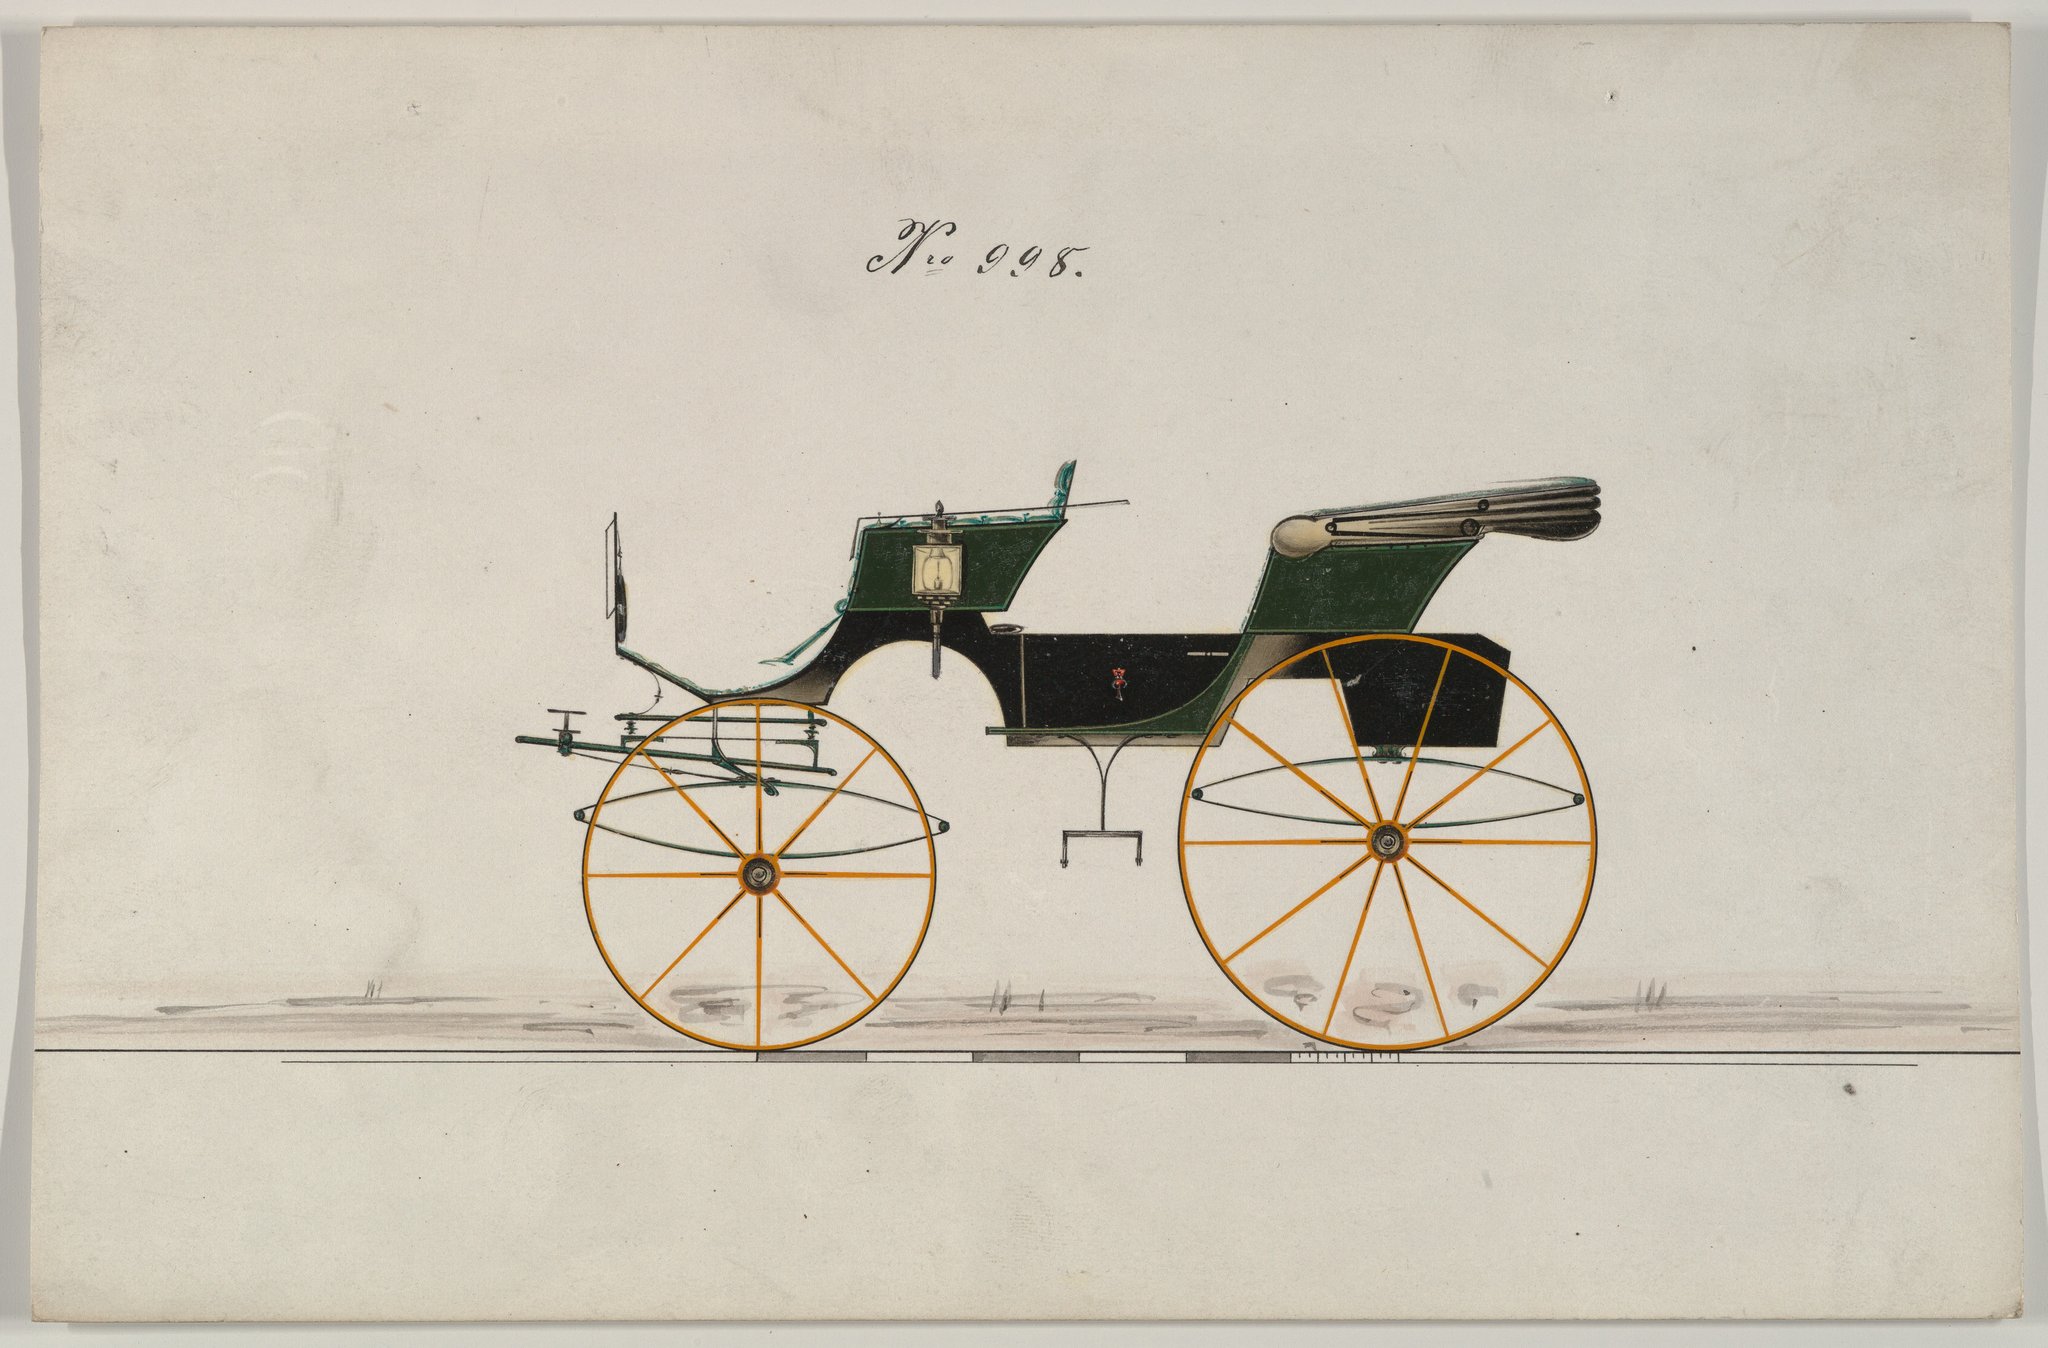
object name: drawing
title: Design for Phaeton, no. 998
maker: brewster & co.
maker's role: manufacturer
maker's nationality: american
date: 1850-1874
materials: gouache, gum arabic, ink, watercolor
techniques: pen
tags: carriages